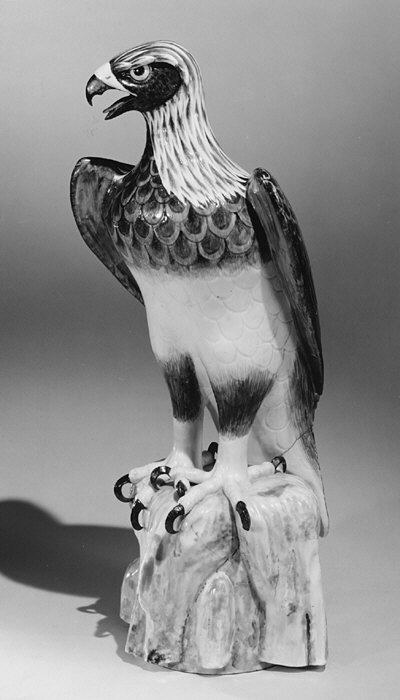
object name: figure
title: Eagle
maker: meissen manufactory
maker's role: manufactory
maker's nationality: german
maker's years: 1710-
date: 1731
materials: hard paste porcelain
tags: eagles